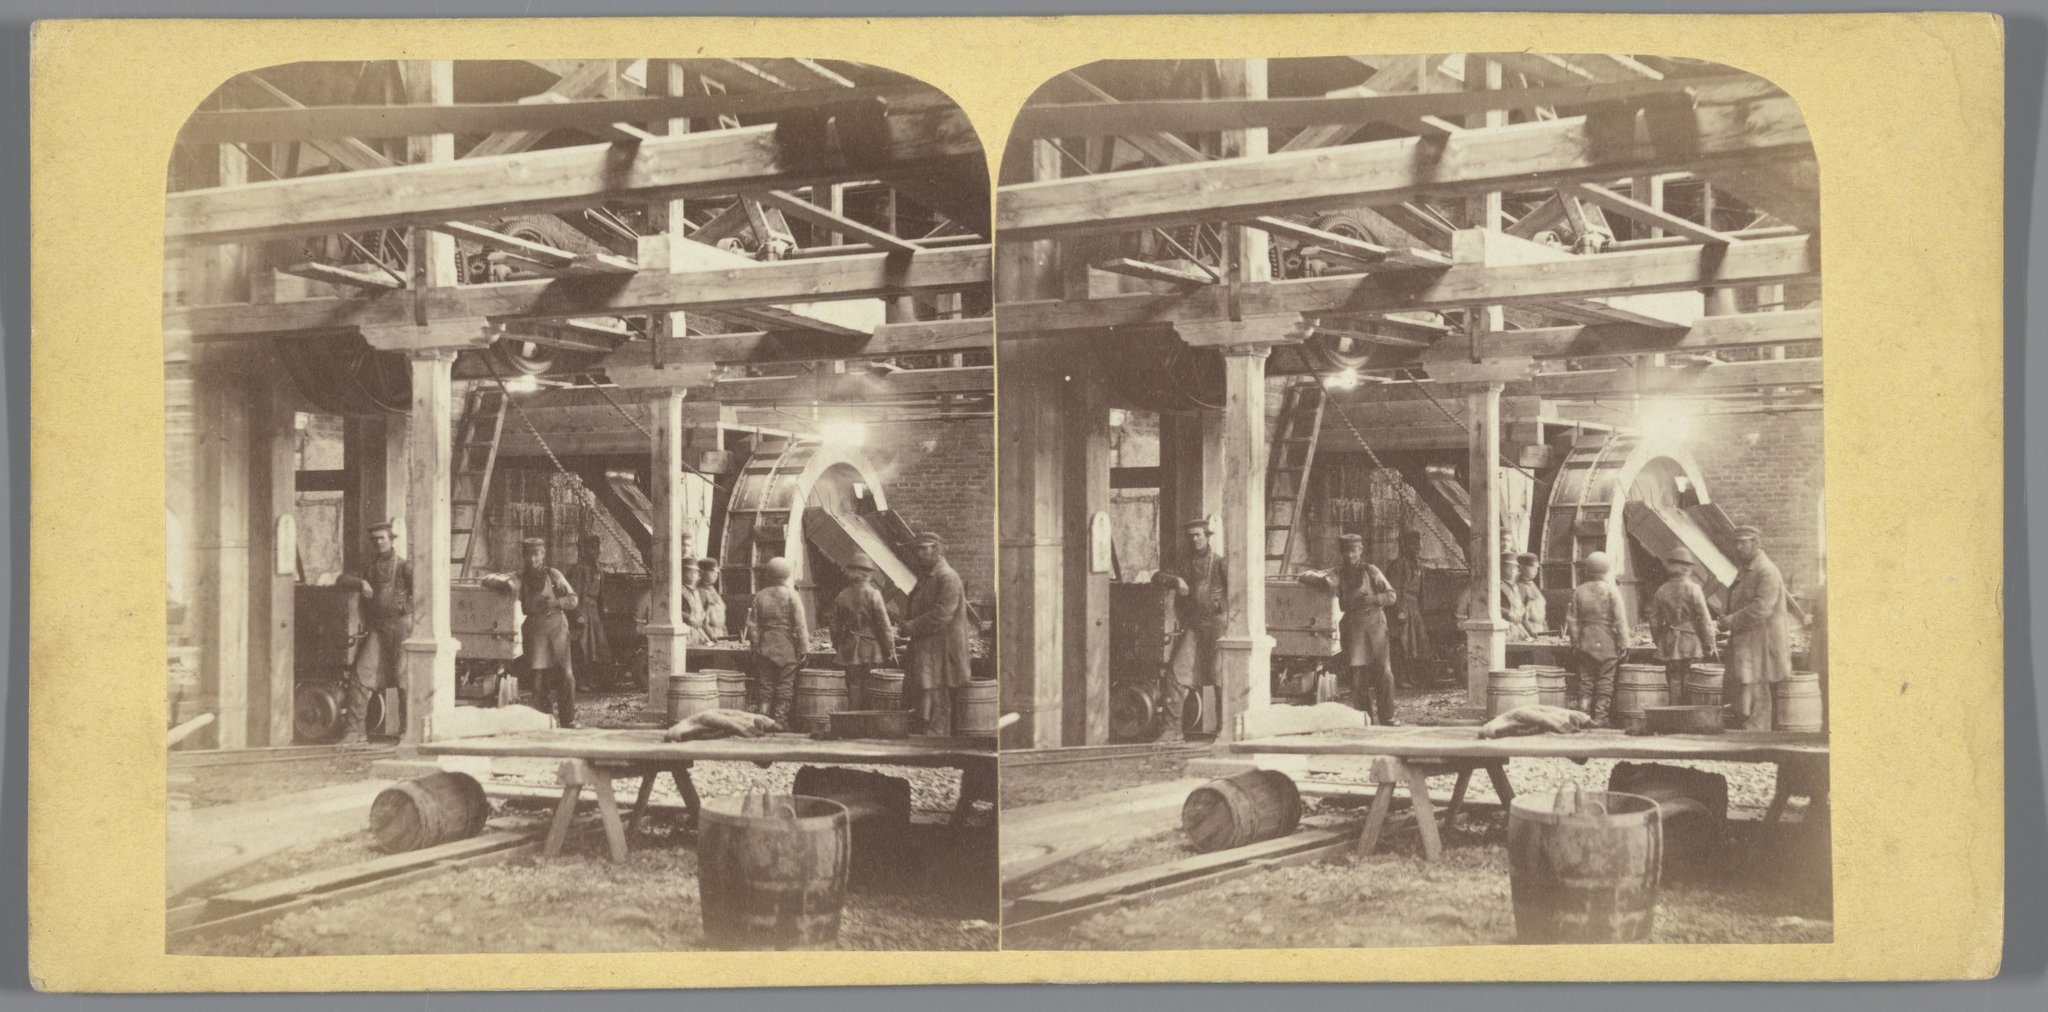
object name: stereograph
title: Interior of a Workshop in the Nygruvan Mine in Sweden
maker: joh. ahlström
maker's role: fotograaf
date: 1867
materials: cardboard, paper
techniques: albumen print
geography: sweden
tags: workshop-interior